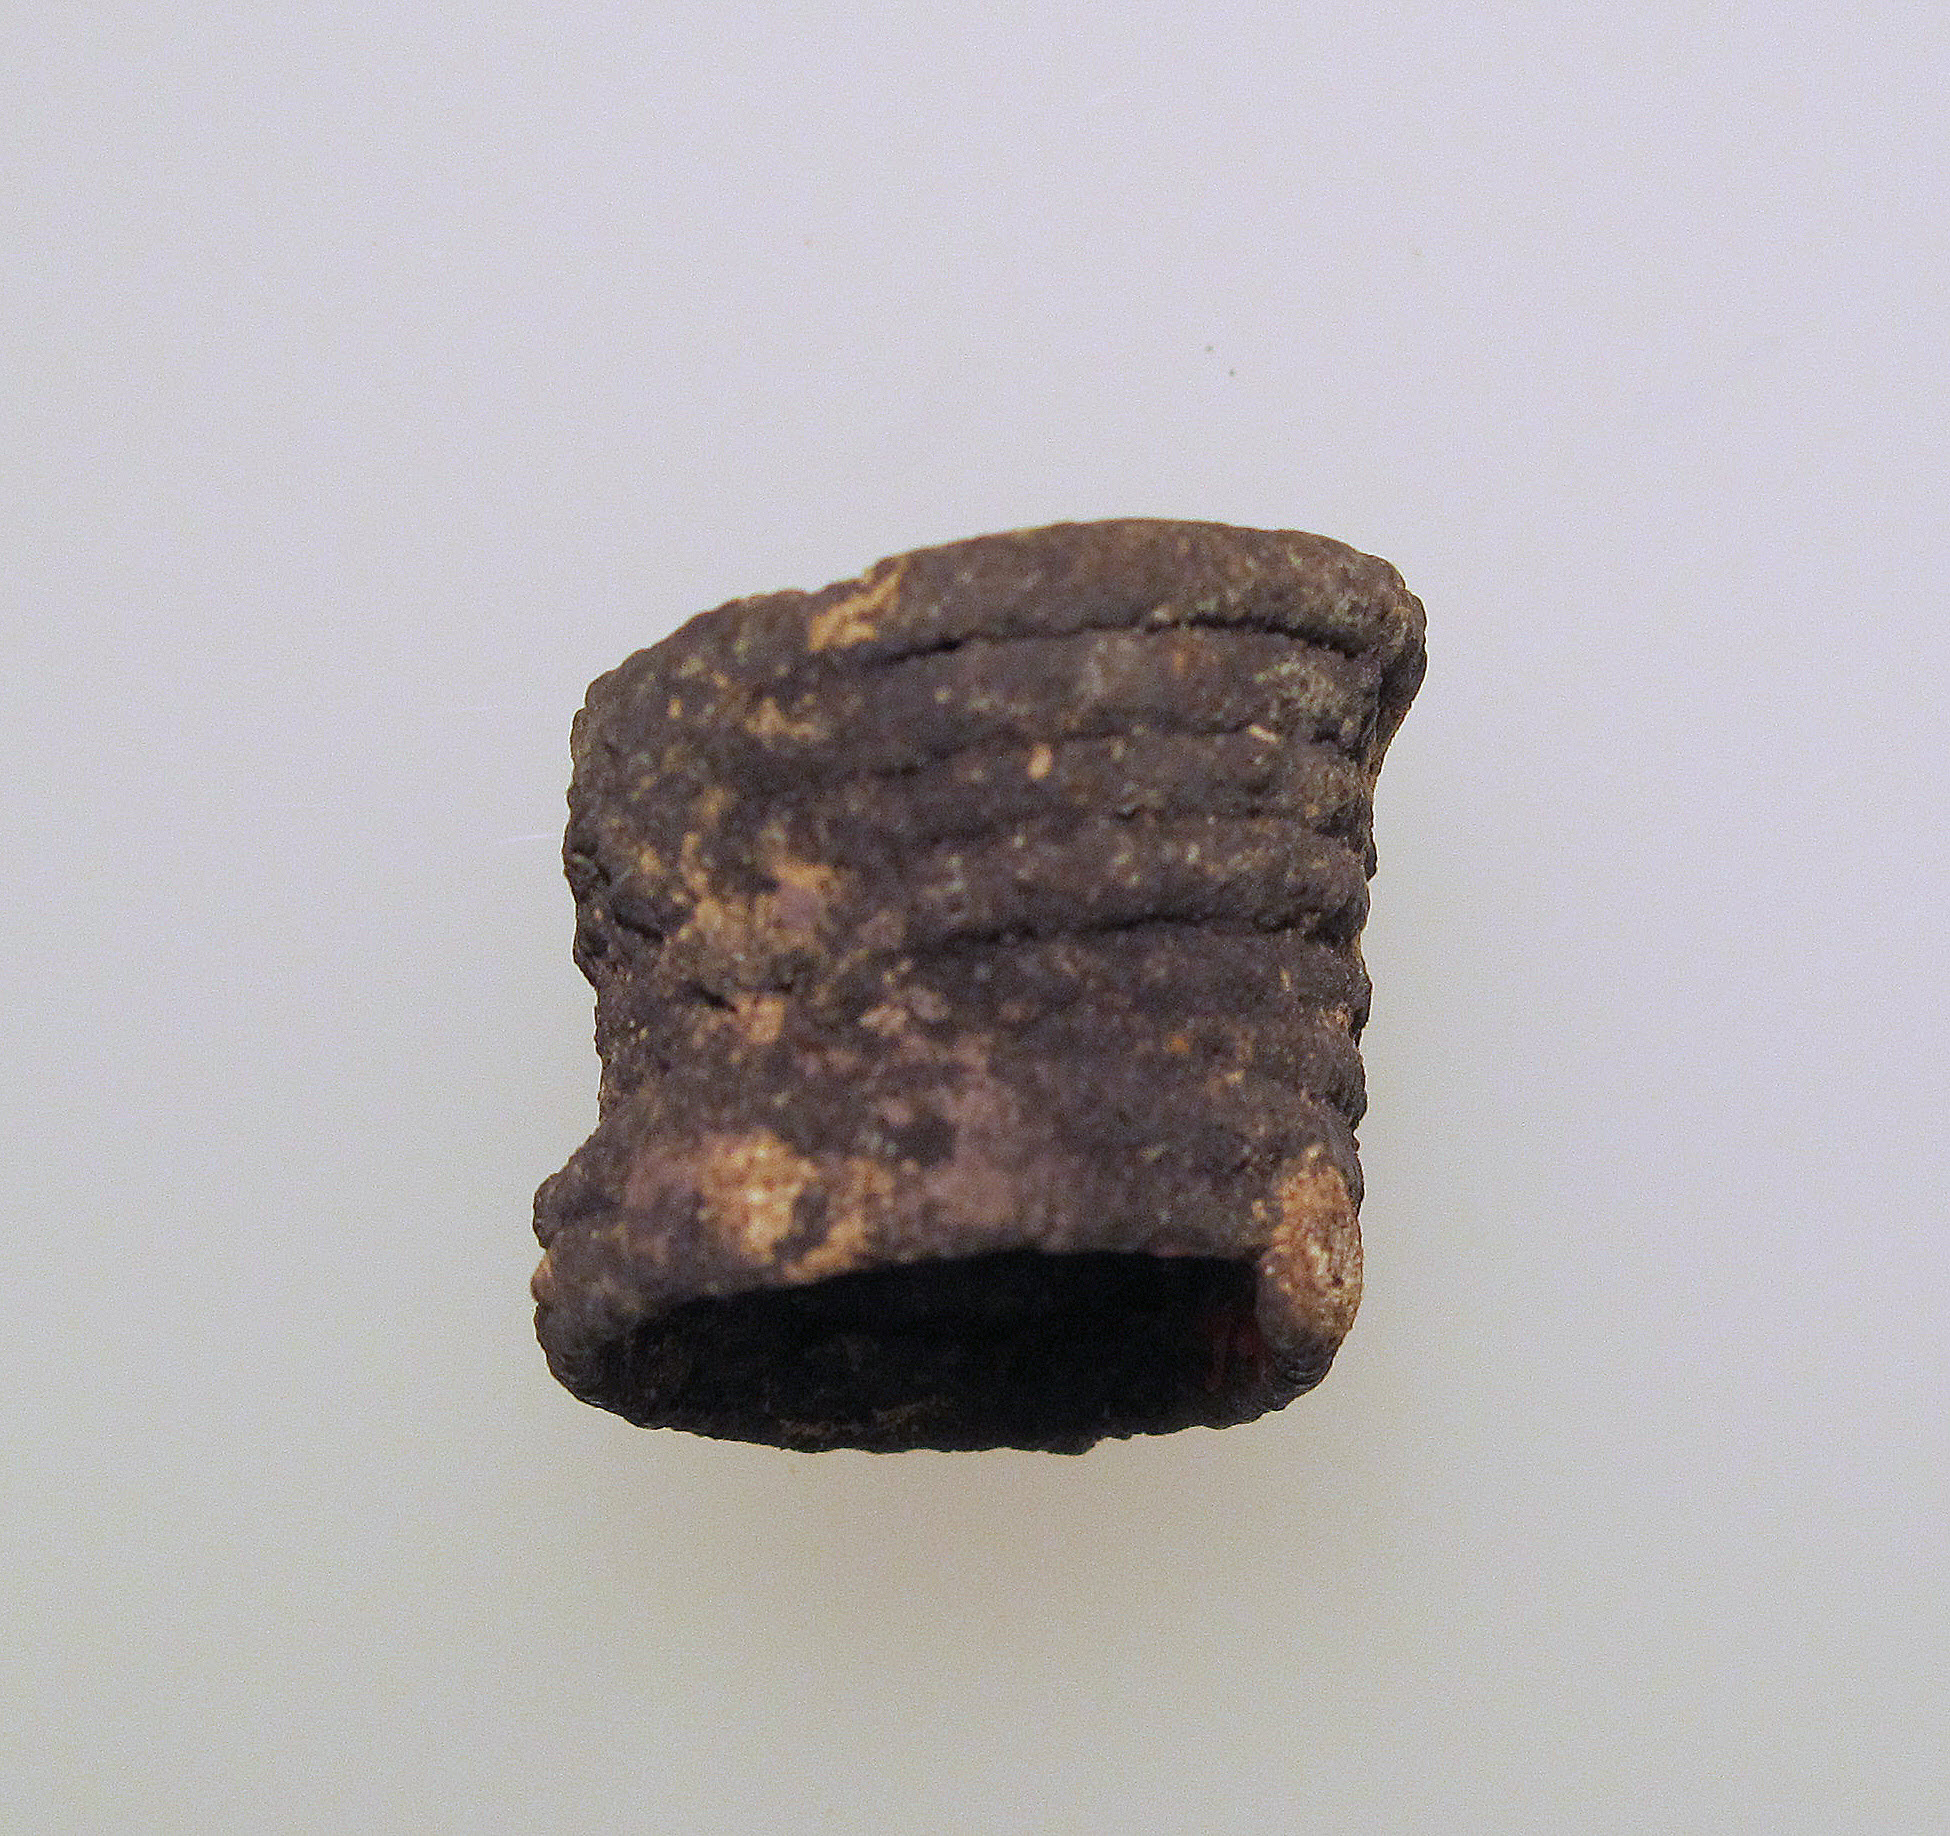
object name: earring or spiral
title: Silver earring or spiral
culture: cypriot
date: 3900 BCE-100 CE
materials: silver